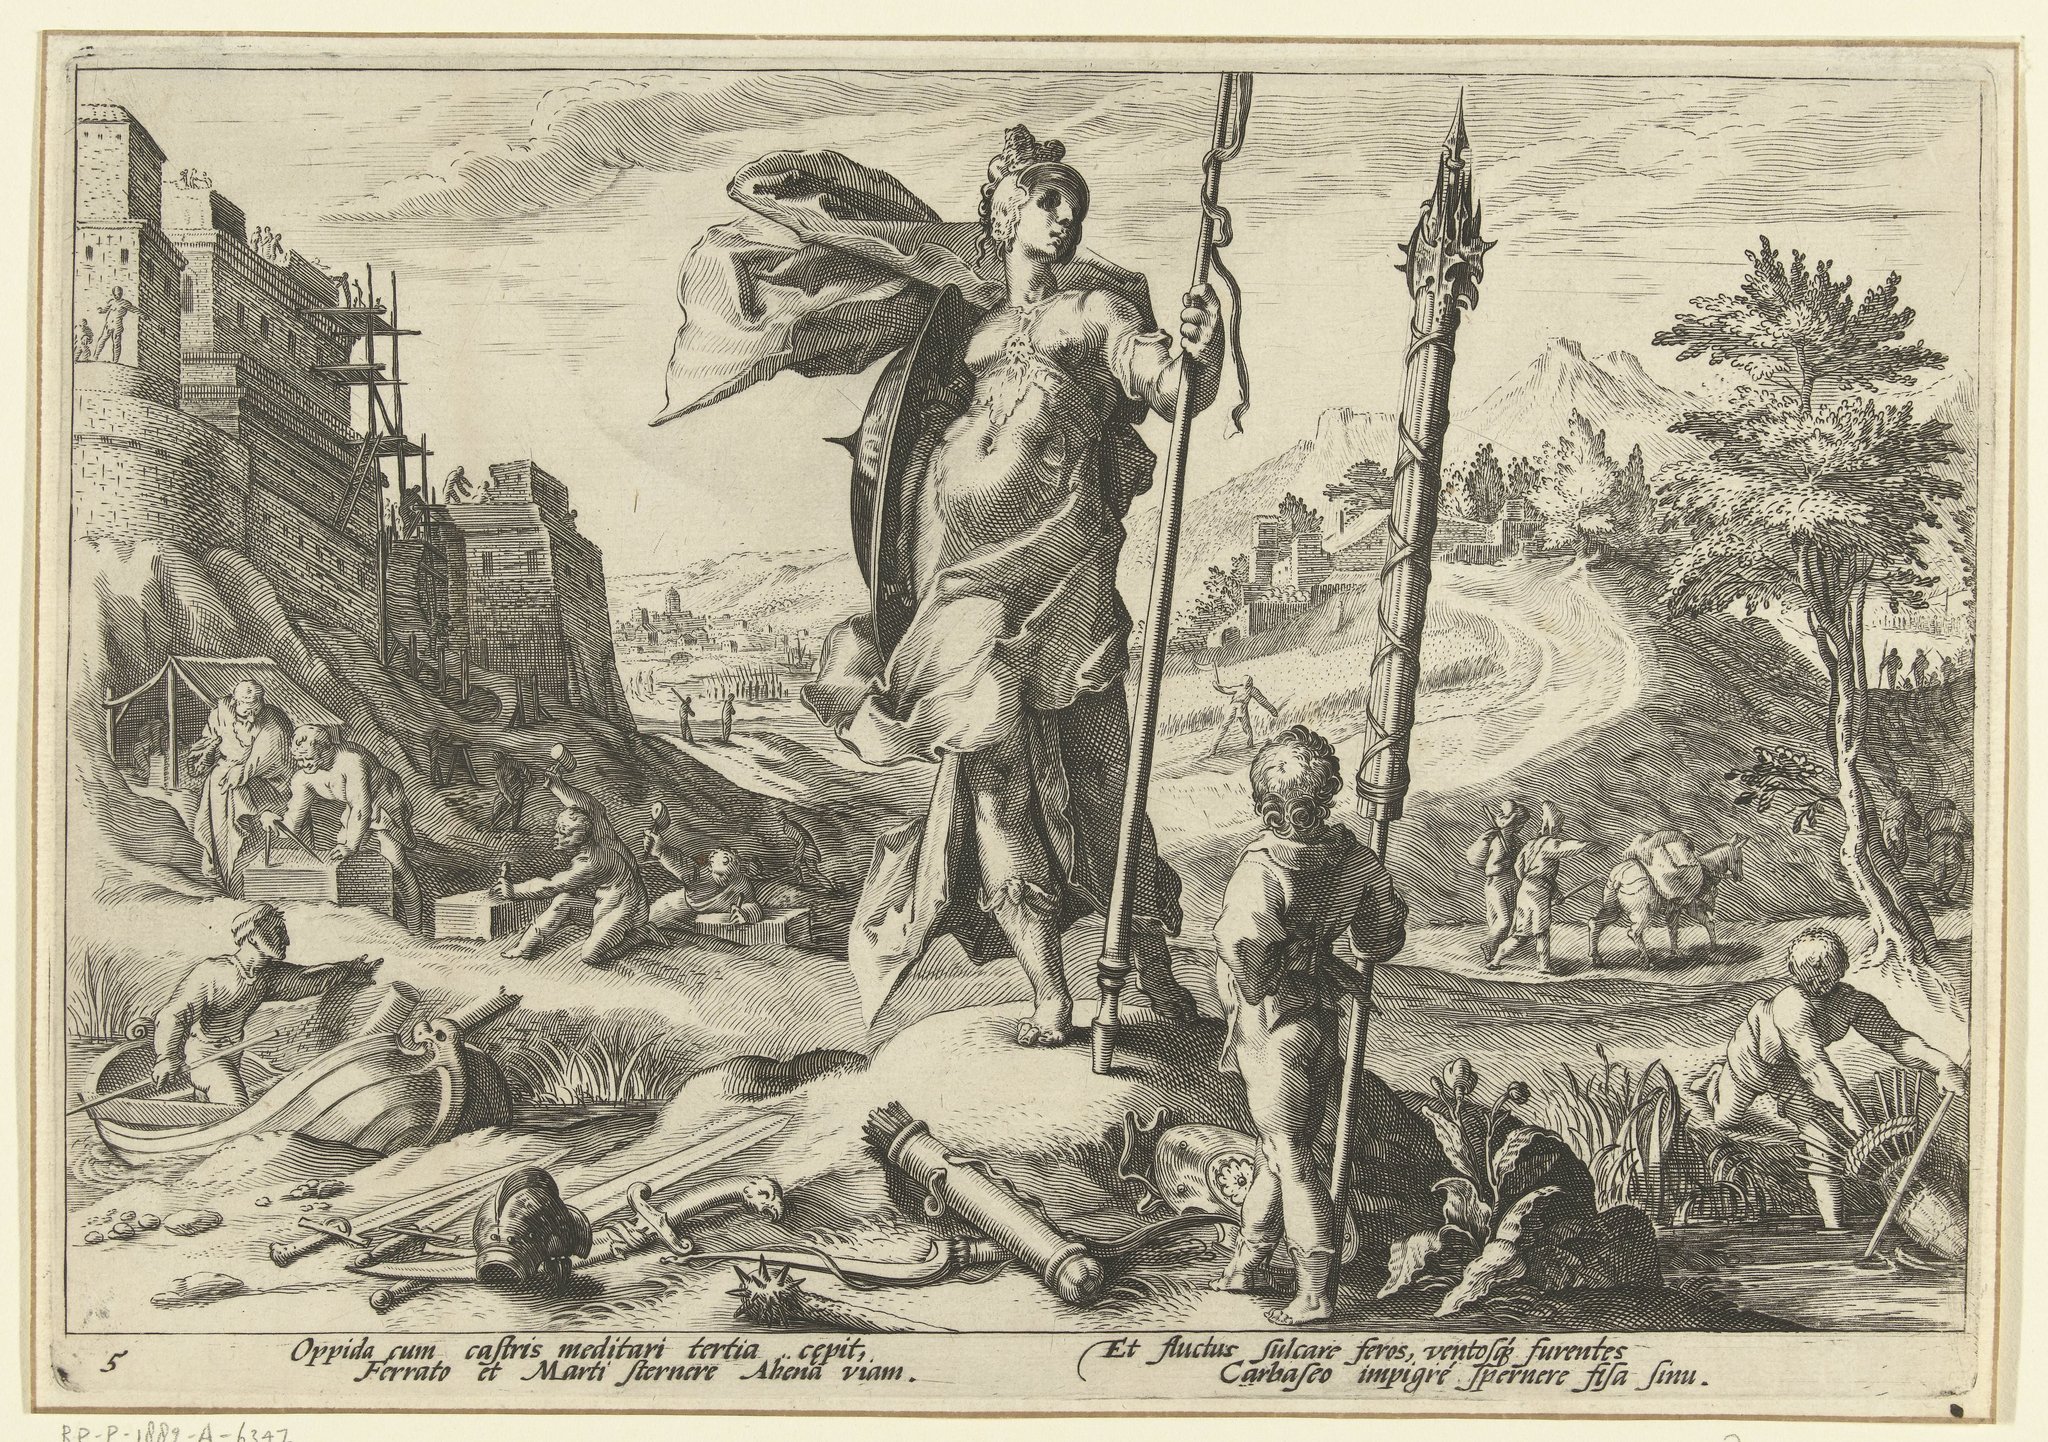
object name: print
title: Bronzen Eeuw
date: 1589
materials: paper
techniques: engraving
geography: haarlem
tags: the bronze age, 'aetas aenea'; characterized by minerva and building activities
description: Verbeelding van het leven tijdens de Bronzen Eeuw: mannen bouwen een groot gebouw. Op de voorgrond de godin Minerva. Voor haar staat een jongen met een bundel steekwapens. Onder de voorstelling twee keer twee regels Latijnse tekst. Deze prent is onderdeel van een serie van 52 prenten die verhalen uit Ovidius' Metamorfosen verbeelden. Deze serie valt uiteen in drie genummerde reeksen: twee van 20 prenten en één van 12 prenten. Deze prent behoort tot de eerste reeks.